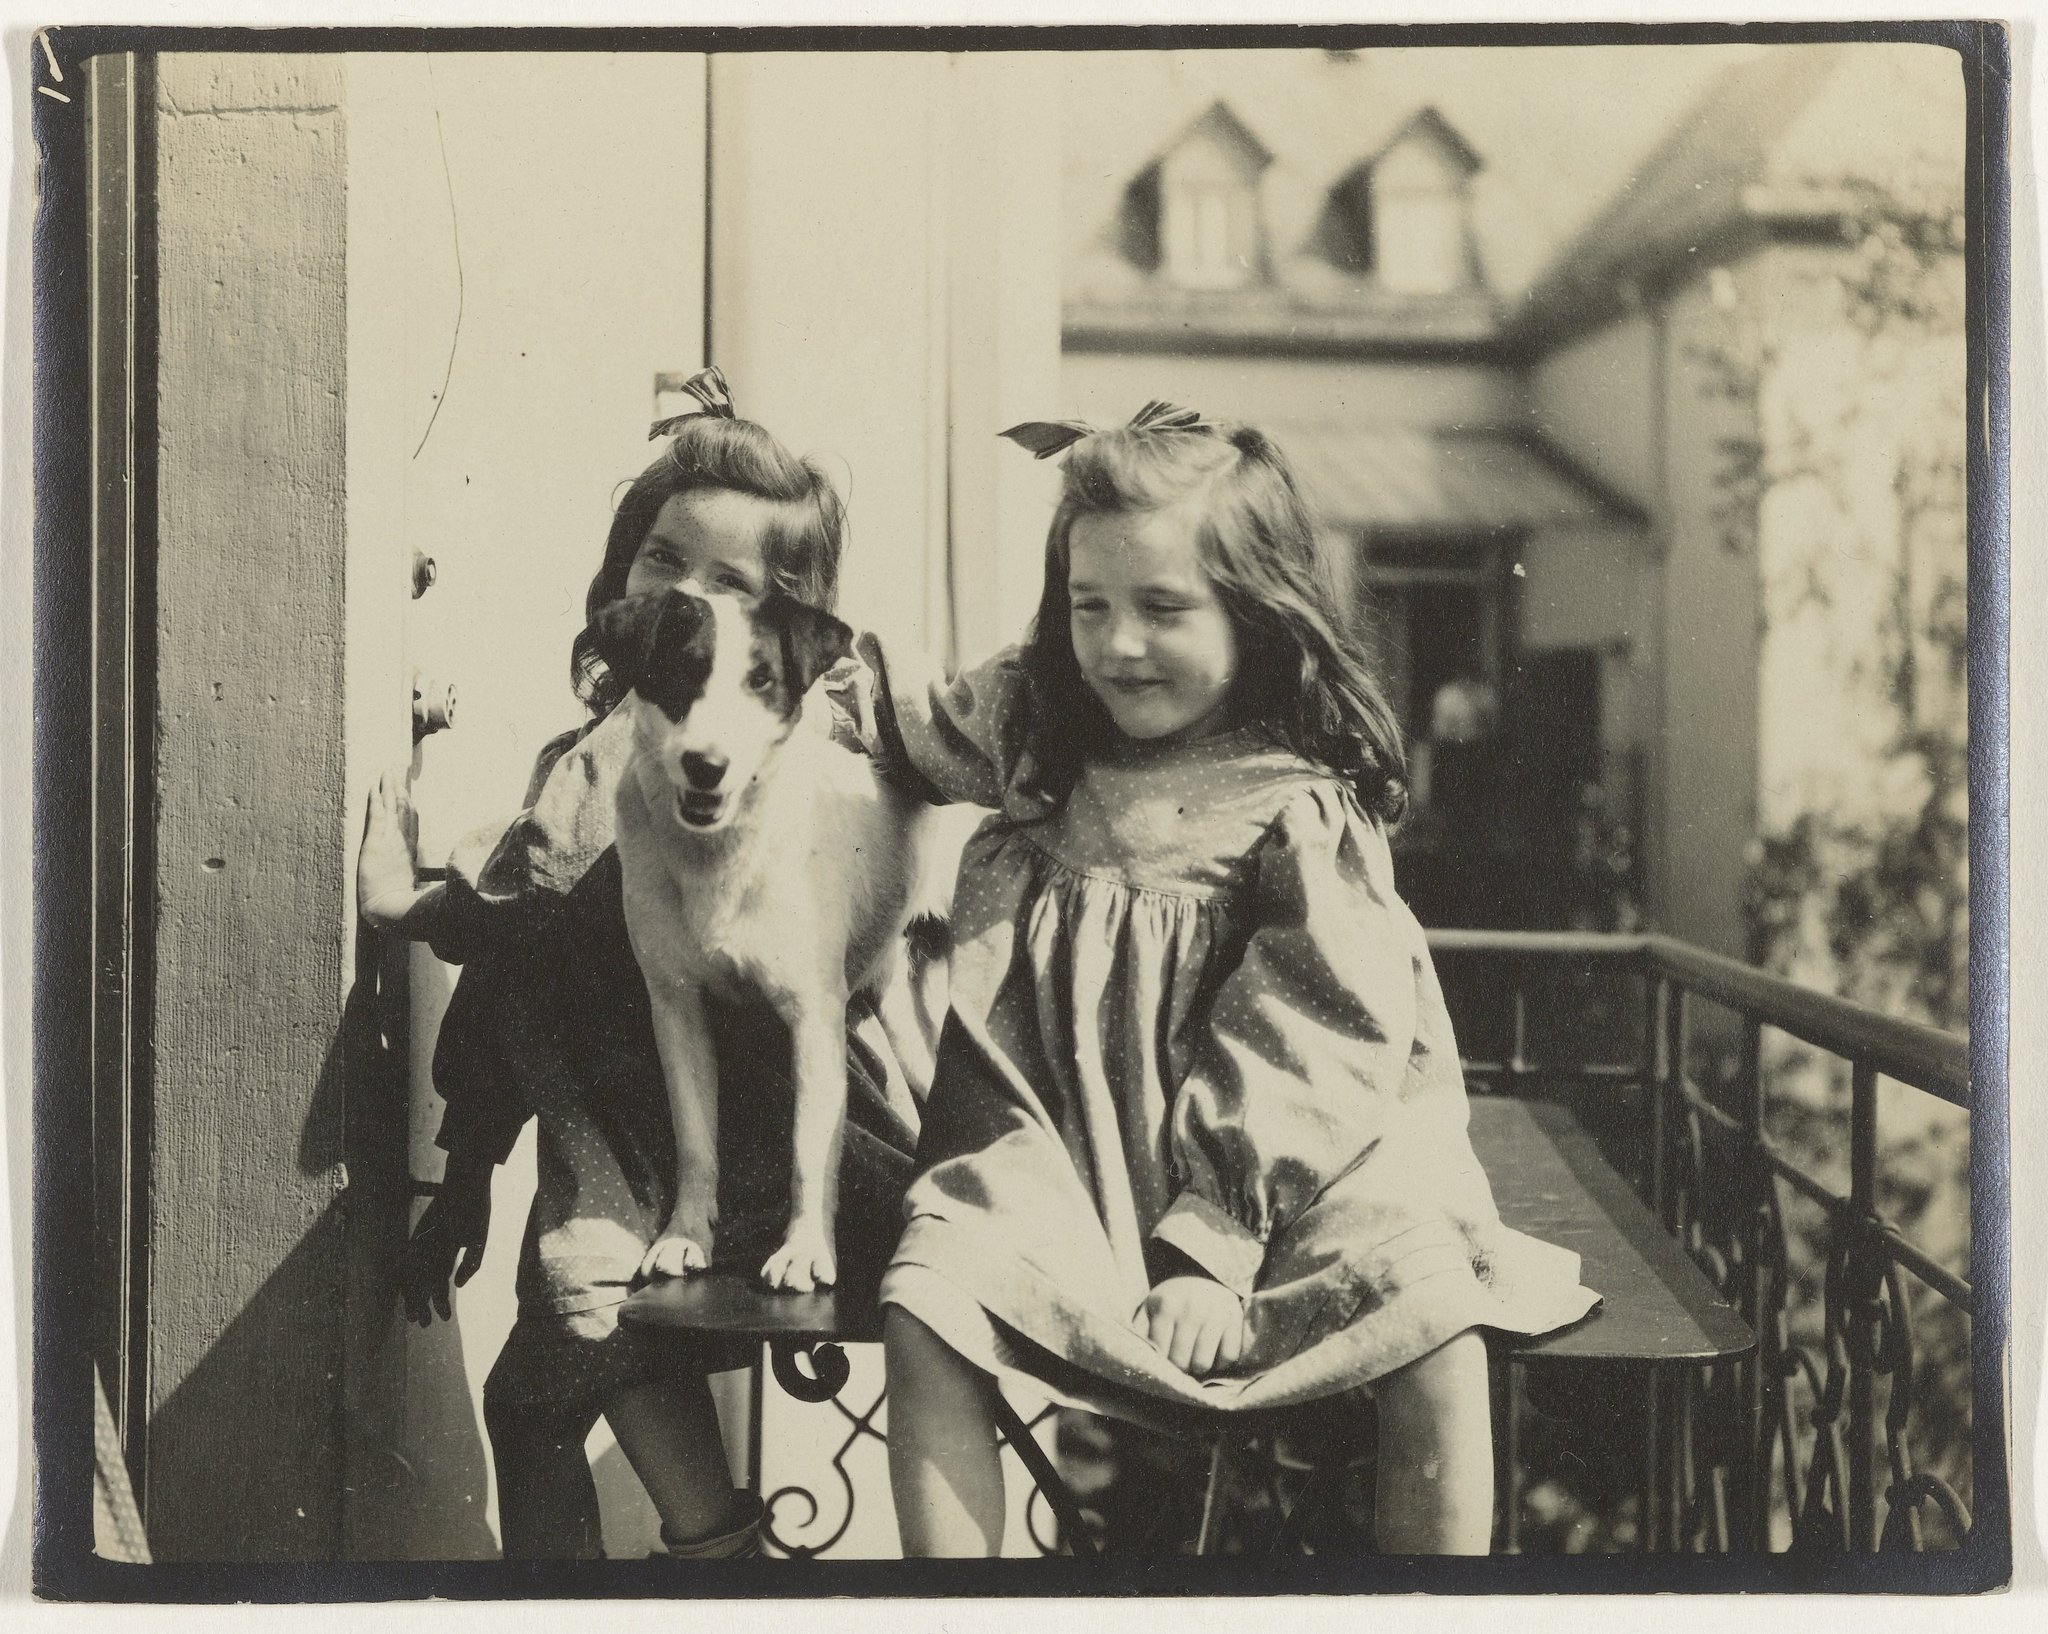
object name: photograph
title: Twee meisjes en een hond op een balkon aan de achterzijde van een huis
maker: Anonymous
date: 1900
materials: paper, photographic support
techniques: gelatin silver print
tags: girl (child between toddler and youth), dog